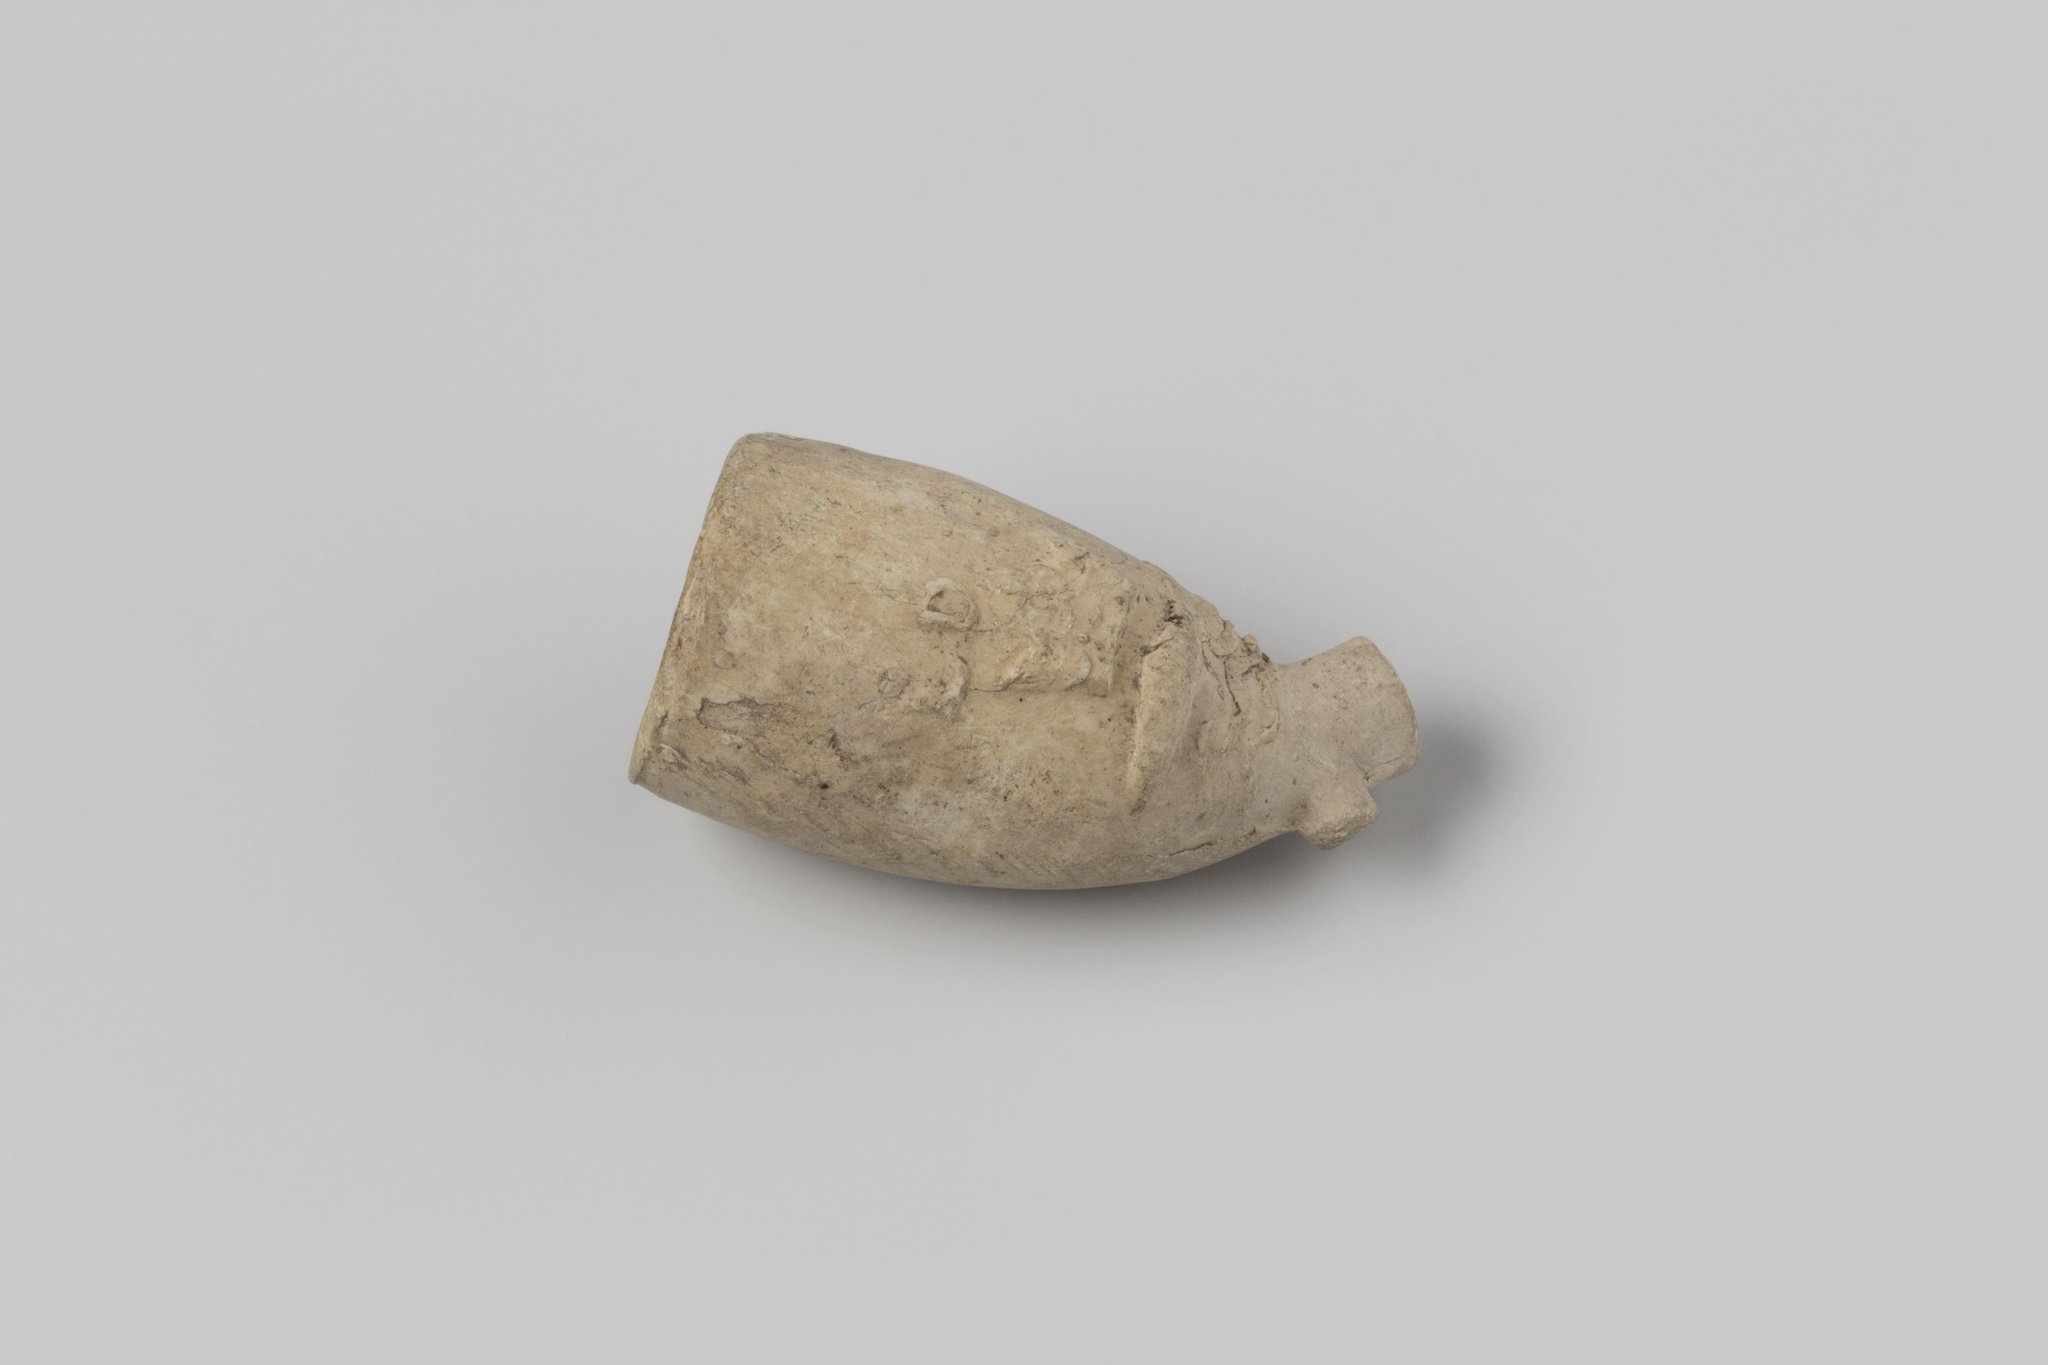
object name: fragment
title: Pijpenkop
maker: jan smit (pijpenfabrikant)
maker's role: pijpenfabrikant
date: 1780-1810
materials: clay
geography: schoonhoven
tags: the hague, rotterdam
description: Pijpenkop met de letters L D I S met gekroonde vis en drie golven. Van de opgravingen op de Hofstede Arentsburg 1827-1831 onder toezicht van Professor Reuvens.